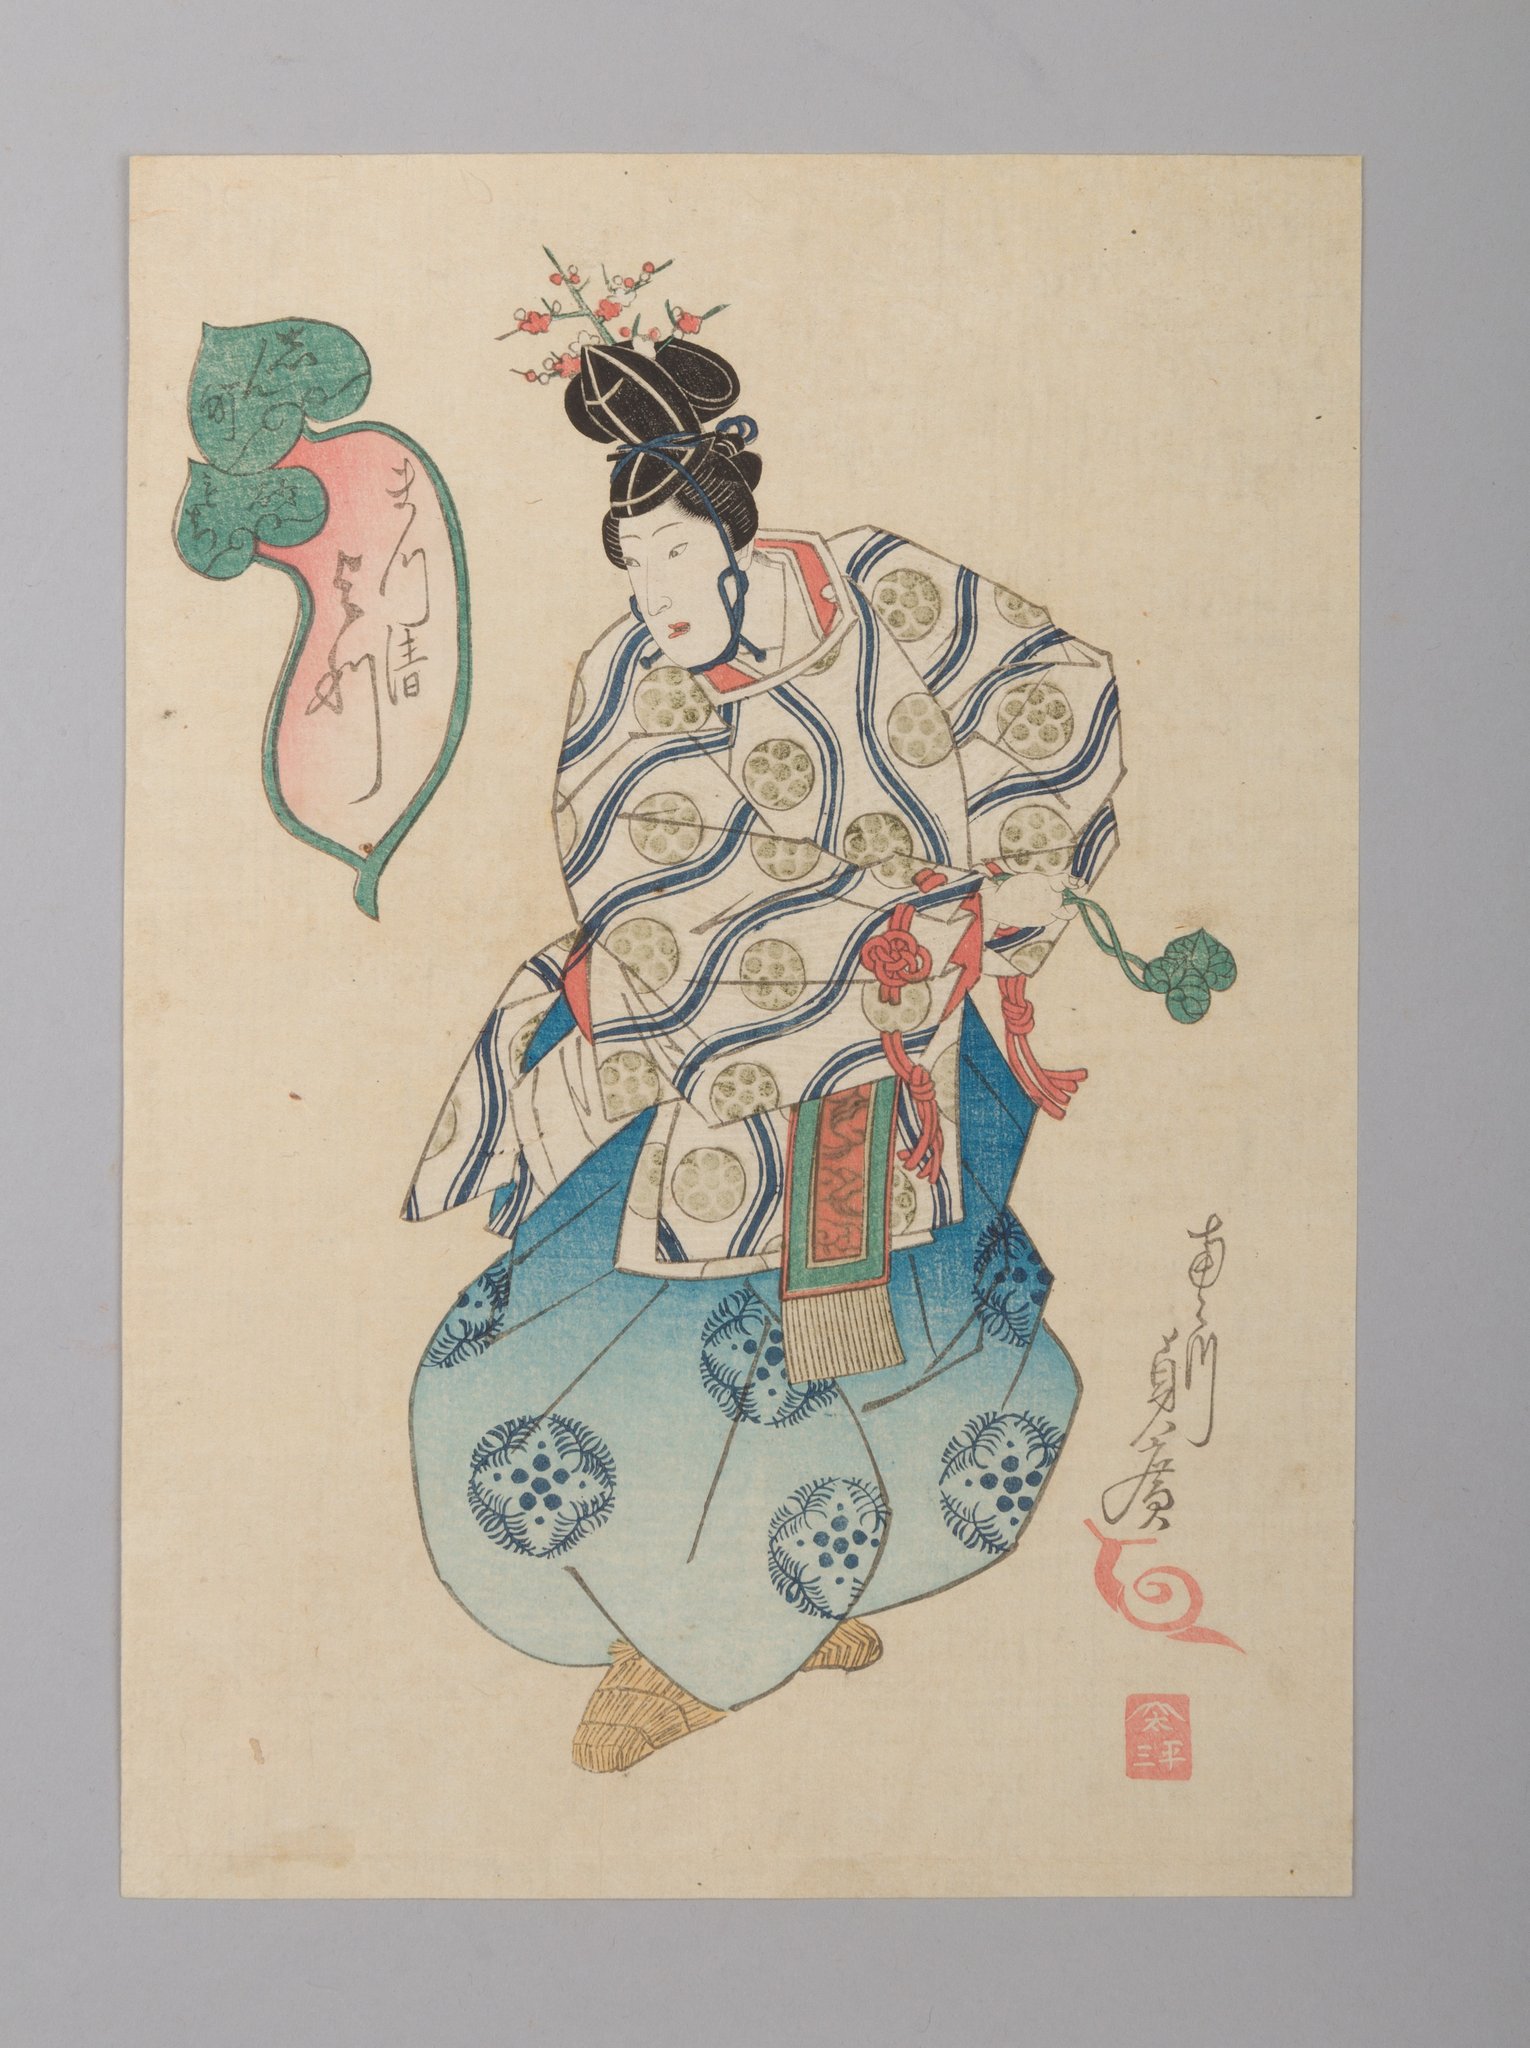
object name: woodblock print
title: Yotsu of the Matsukiyo Brothel Performing as a Shirabyōshi, from the series Sacred Dances in Shinmachi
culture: japanese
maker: gochōtei sadahiro 五蝶亭貞広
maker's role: artist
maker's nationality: japanese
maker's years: 1825-1859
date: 1841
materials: ink, paper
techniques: nishiki e, woodblock print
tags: men,actors